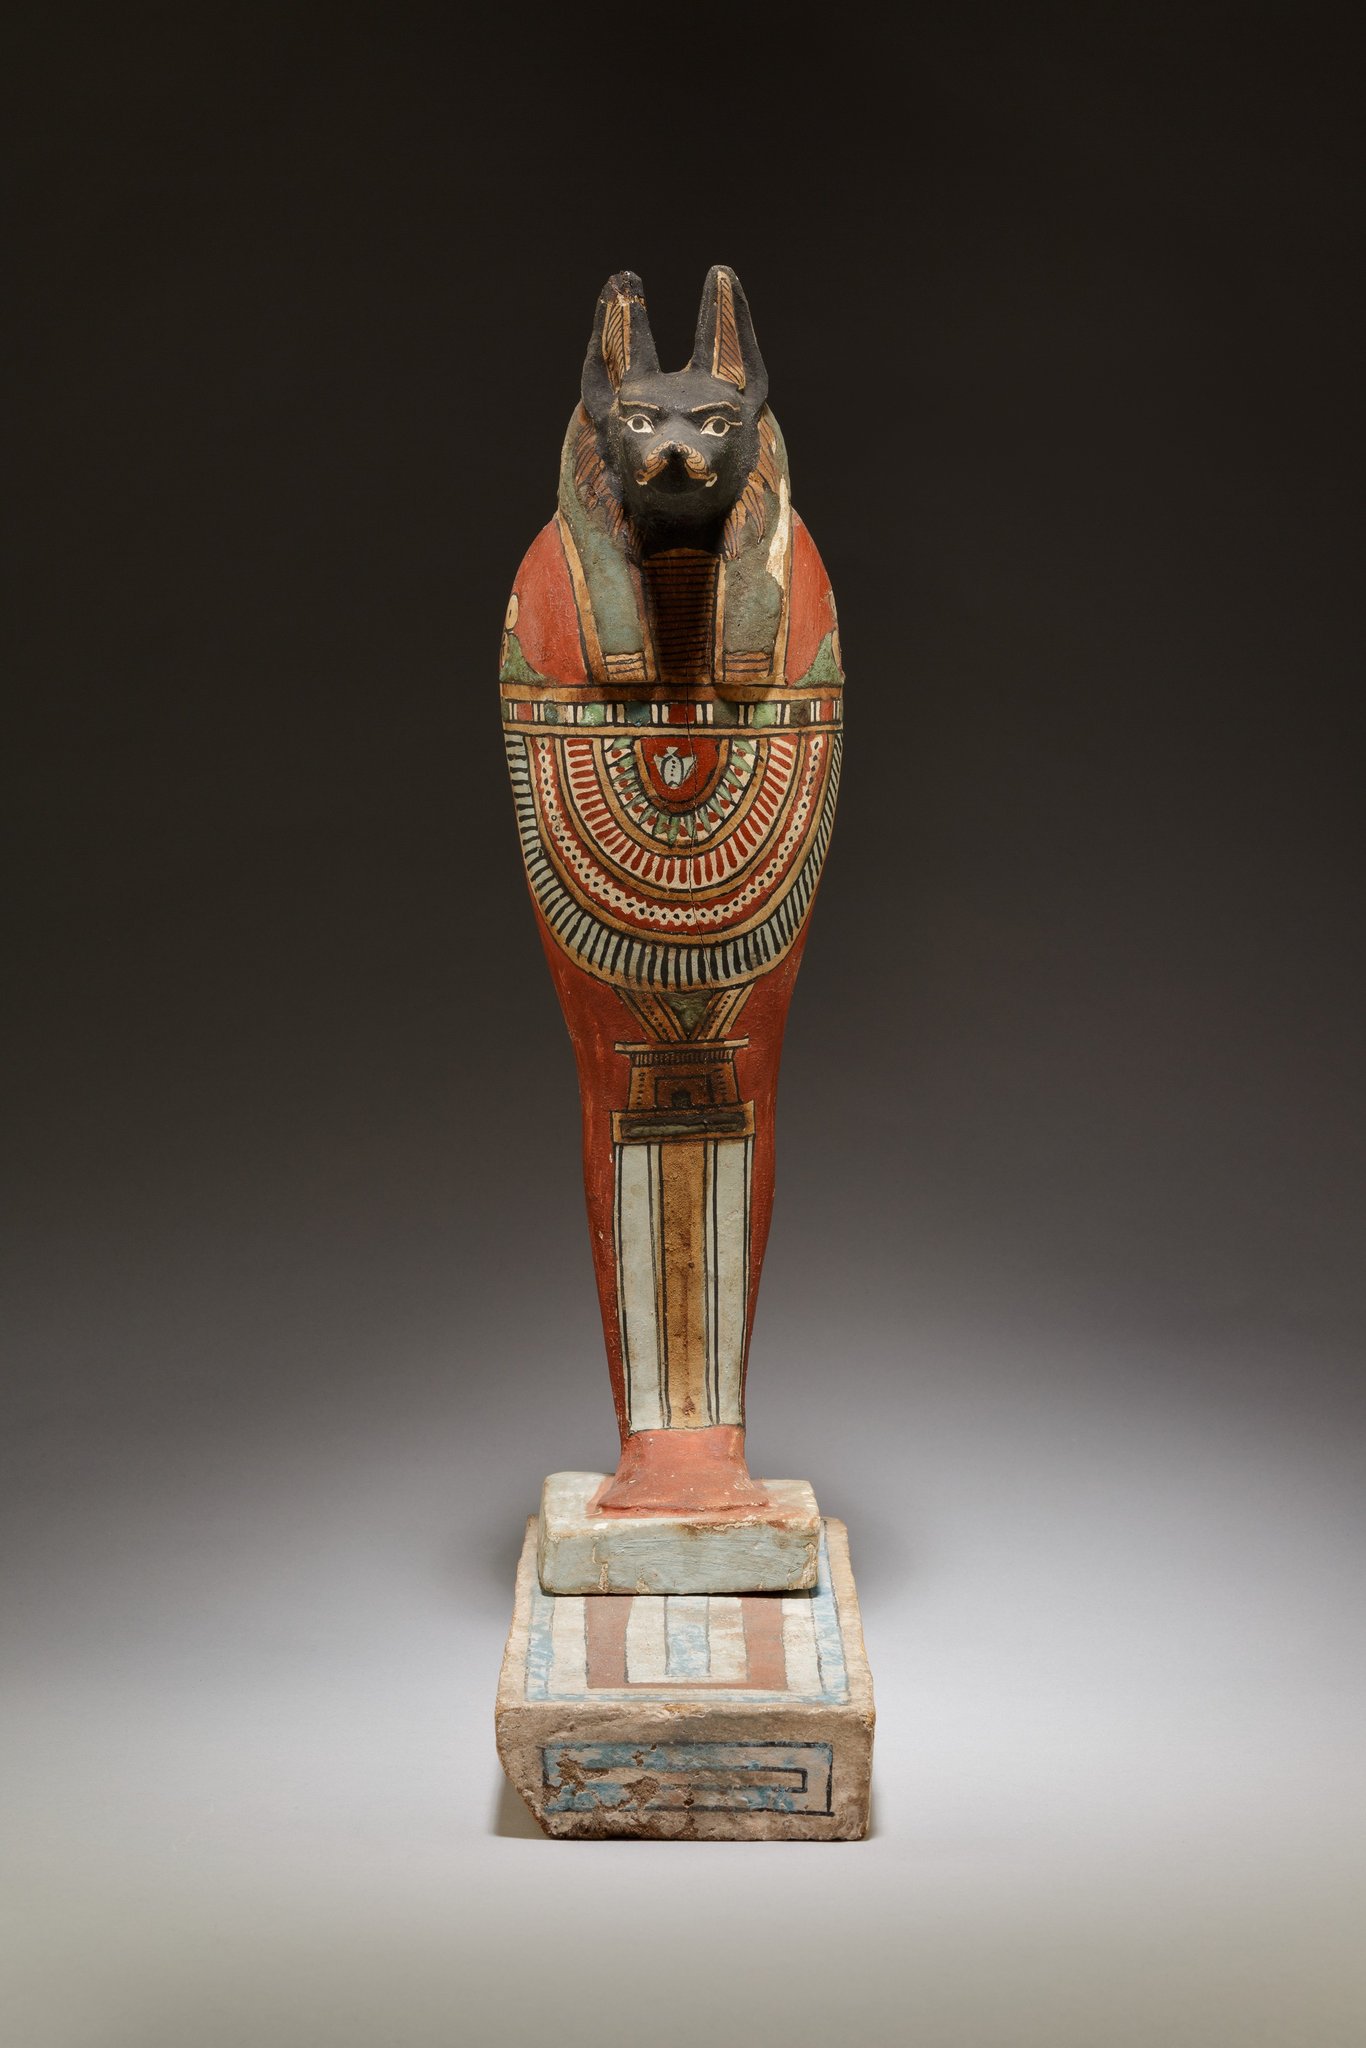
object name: funerary figure, duamutef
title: Funerary Figure of Duamutef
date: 400-30 BCE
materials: wood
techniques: painting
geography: middle egypt